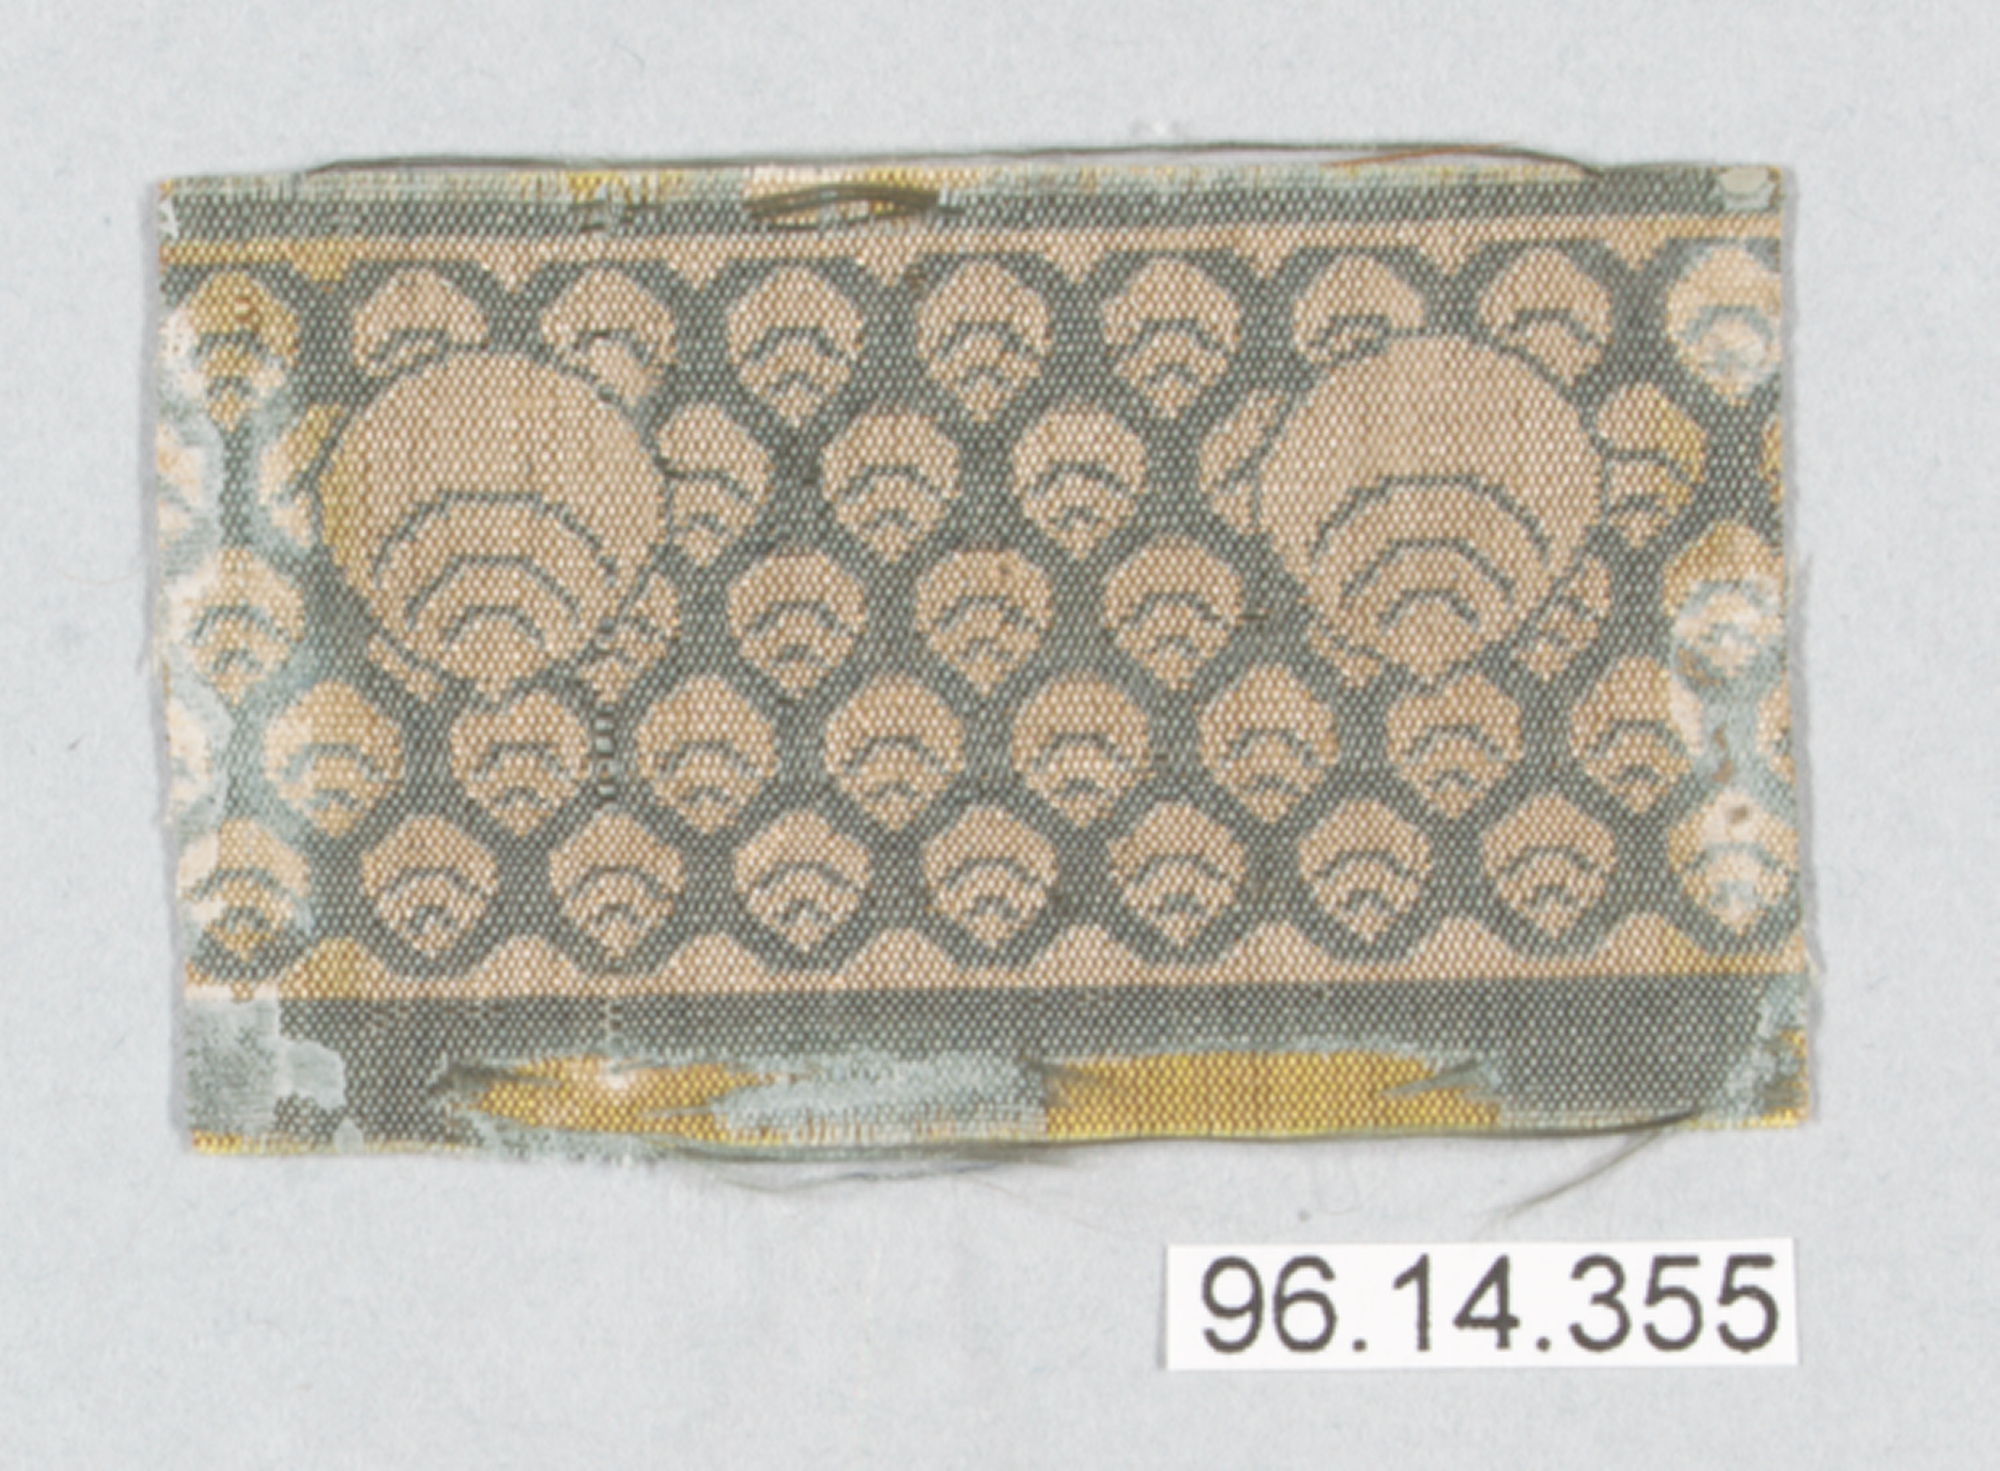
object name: piece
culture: japanese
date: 1701-1900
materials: silk